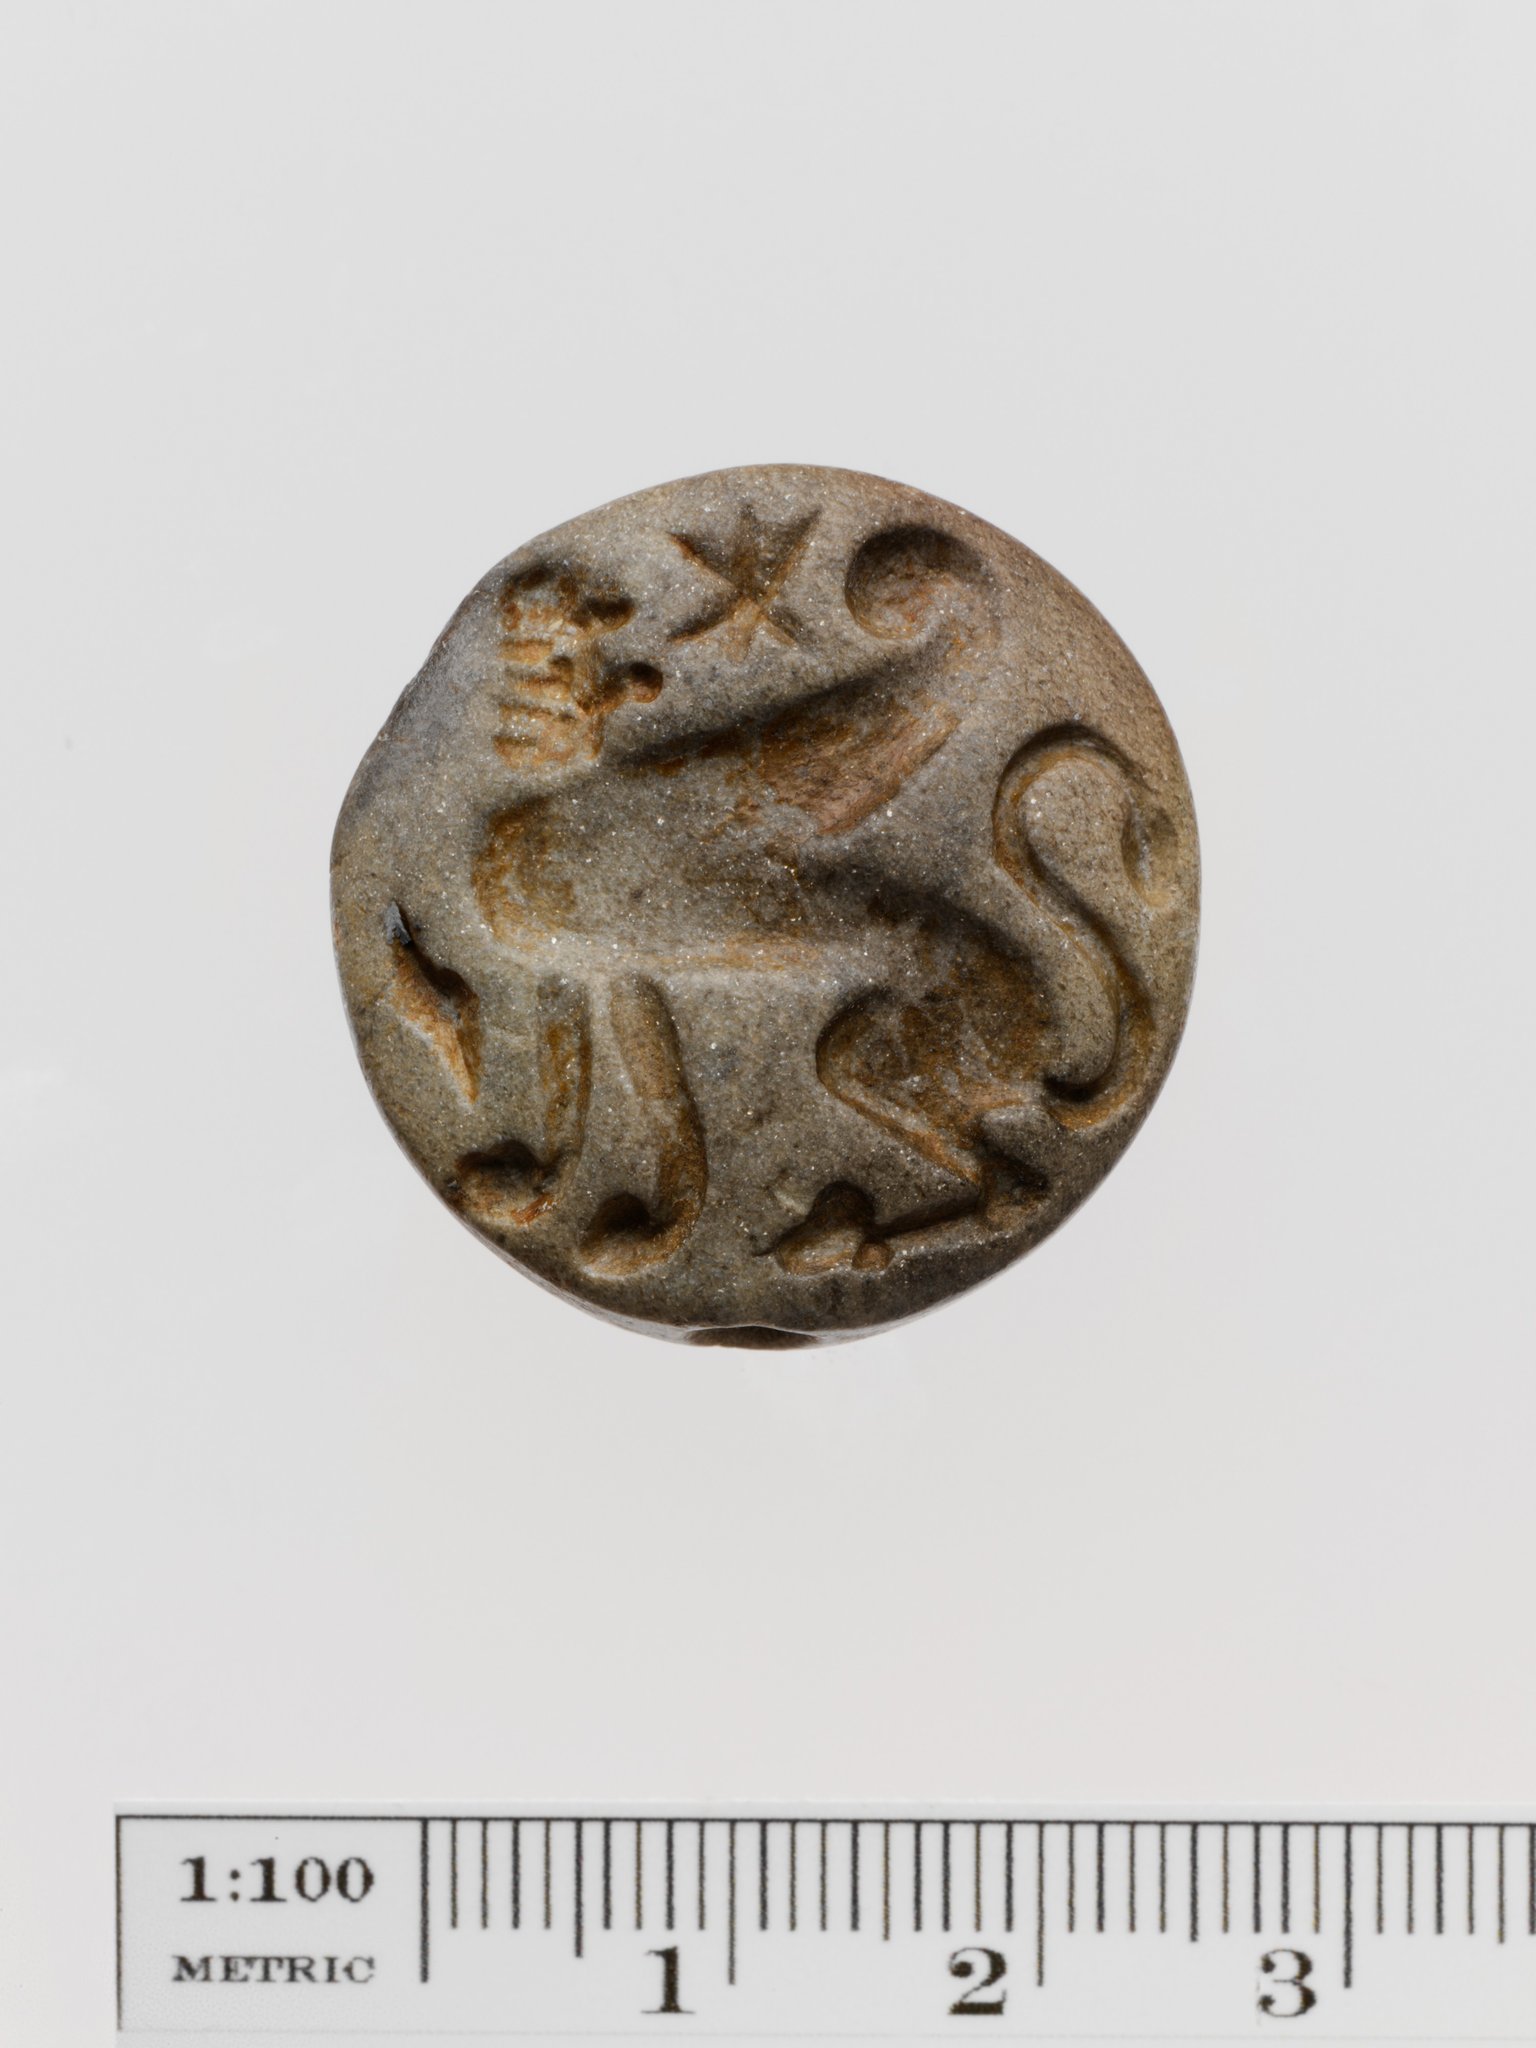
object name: intaglio amulet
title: Micaceous stone lentoid seal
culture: greek, melian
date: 650-601 BCE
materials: stone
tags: sphinx